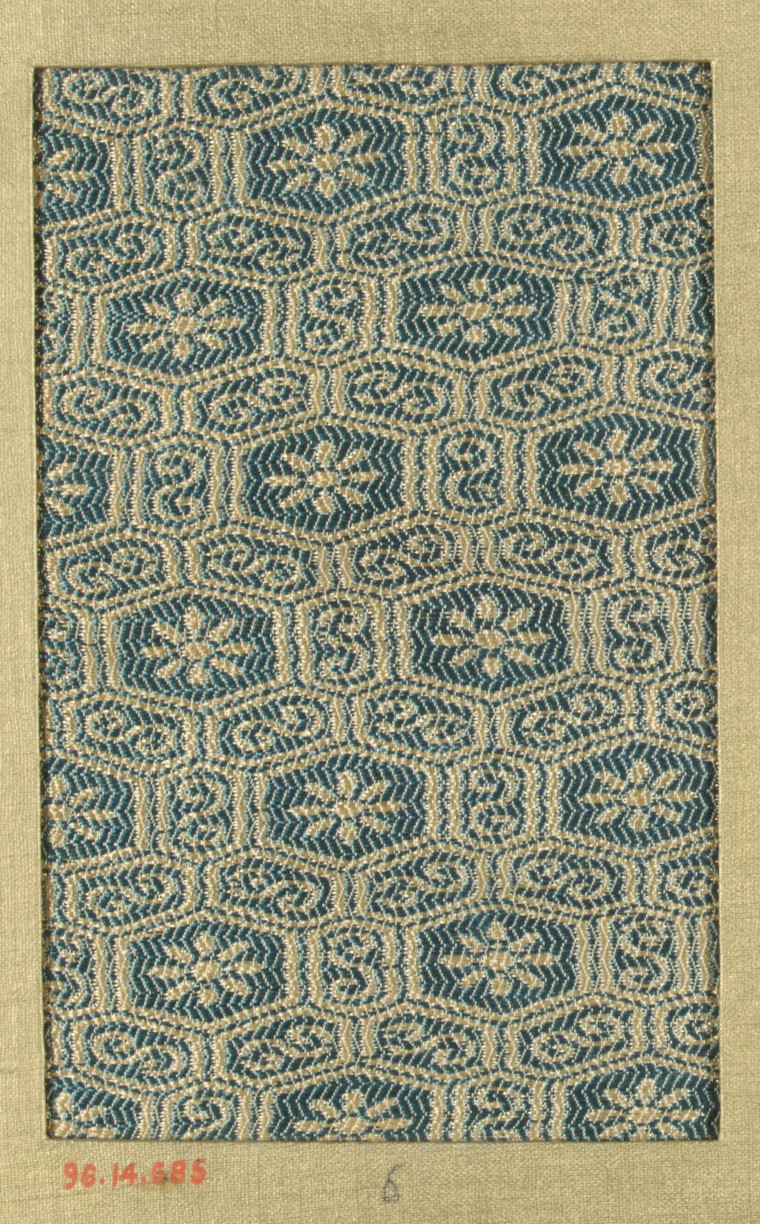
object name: piece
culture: japanese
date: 1701-1900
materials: silk